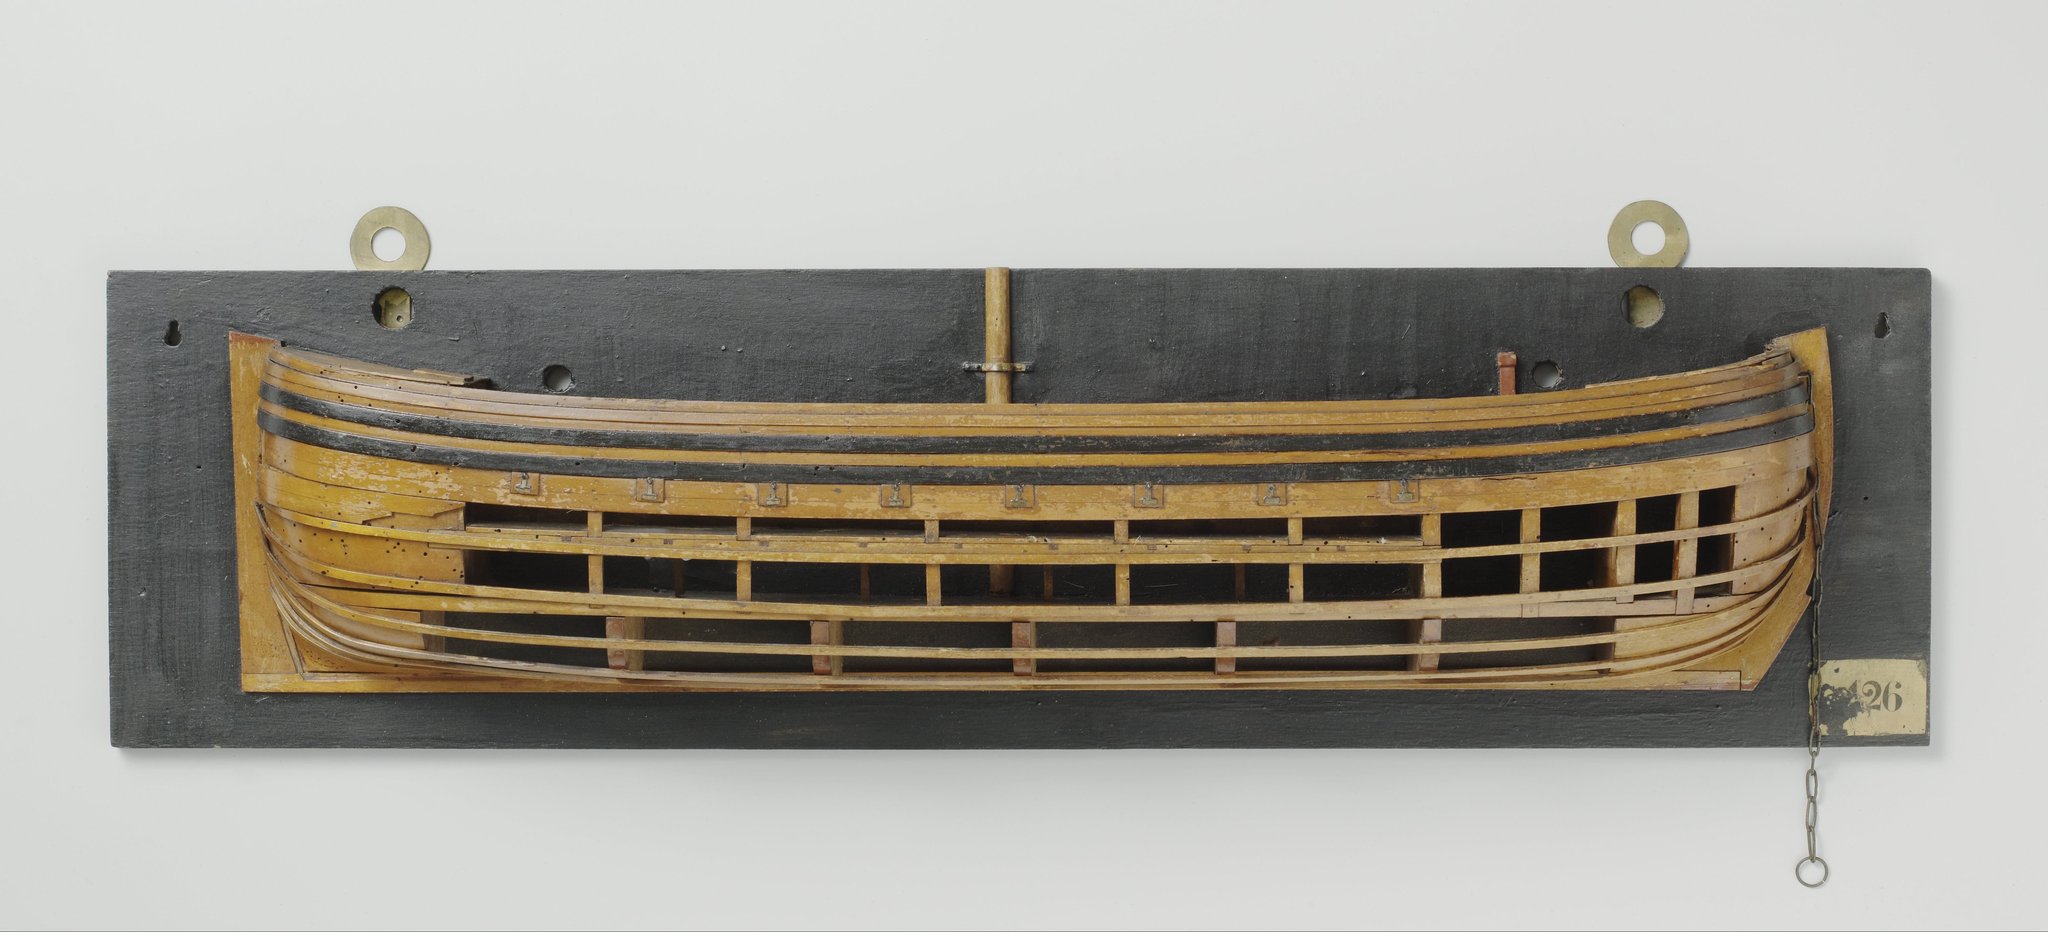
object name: half model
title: Half Model of a Fireship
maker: Anonymous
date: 1795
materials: brass, paint, wood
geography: netherlands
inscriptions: label, bottom right: ‘426’ former inventory label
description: Volgens Obreen werd dit schip in 1795 gebouwd als of ingericht als brander.